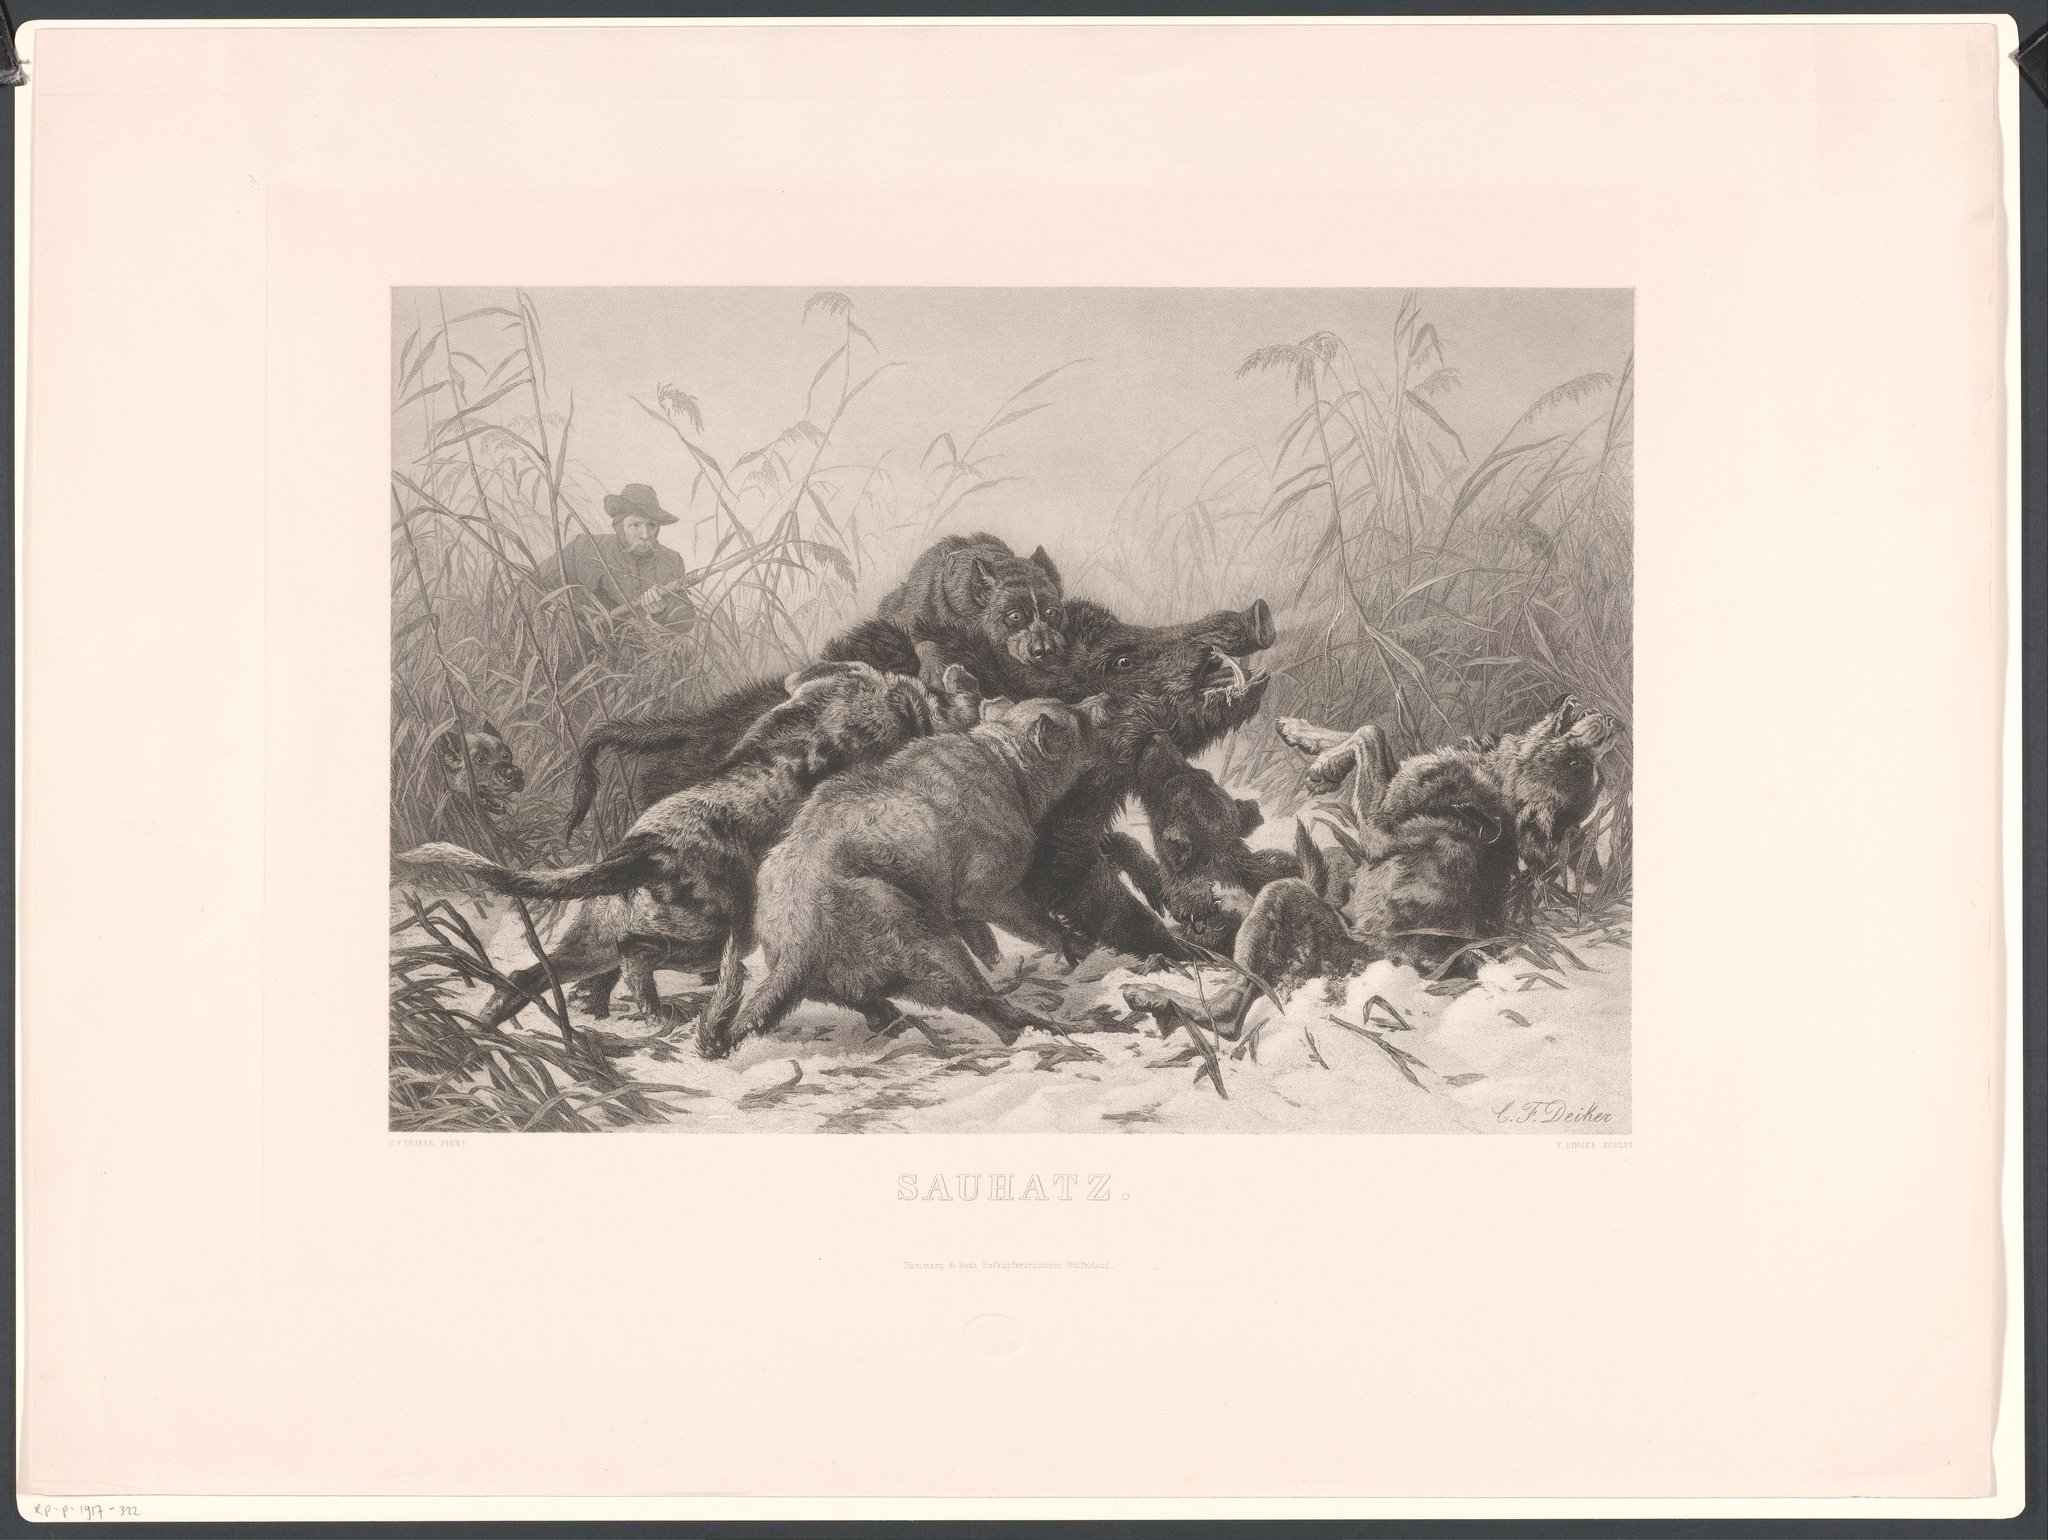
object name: print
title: Sauhatz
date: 1837-1904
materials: paper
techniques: engraving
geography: dusseldorf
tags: boar-hunting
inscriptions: collector's mark: Lugt 2228